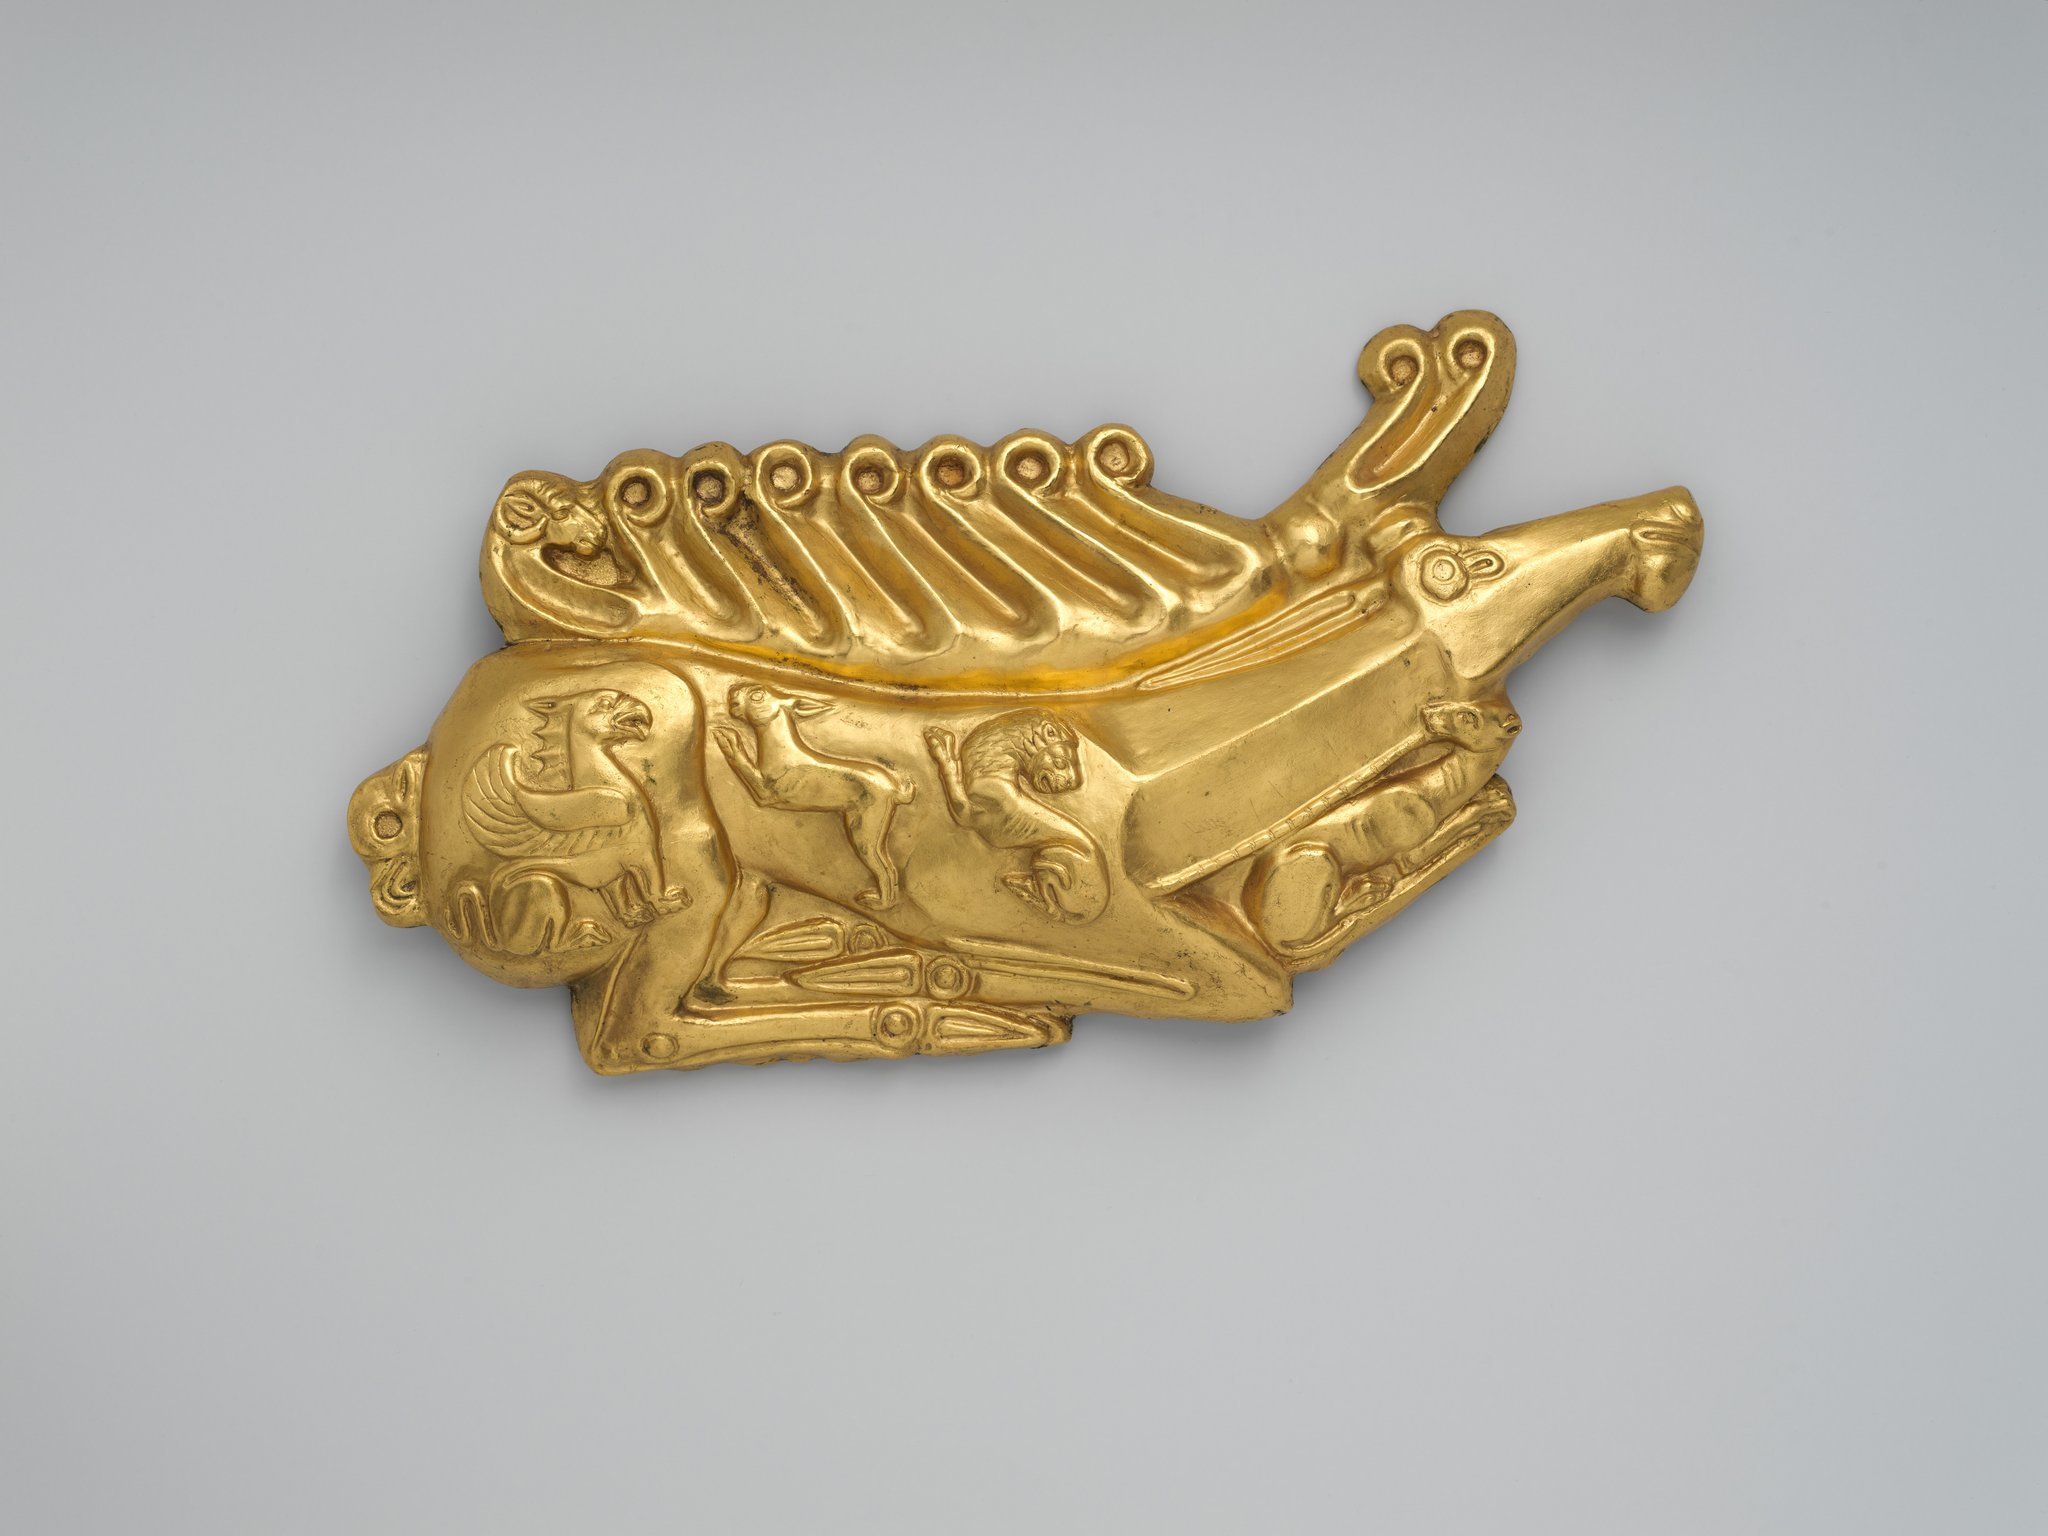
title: Reproduction of a Scythian plaque in the form of a reclining stag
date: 1801-1900